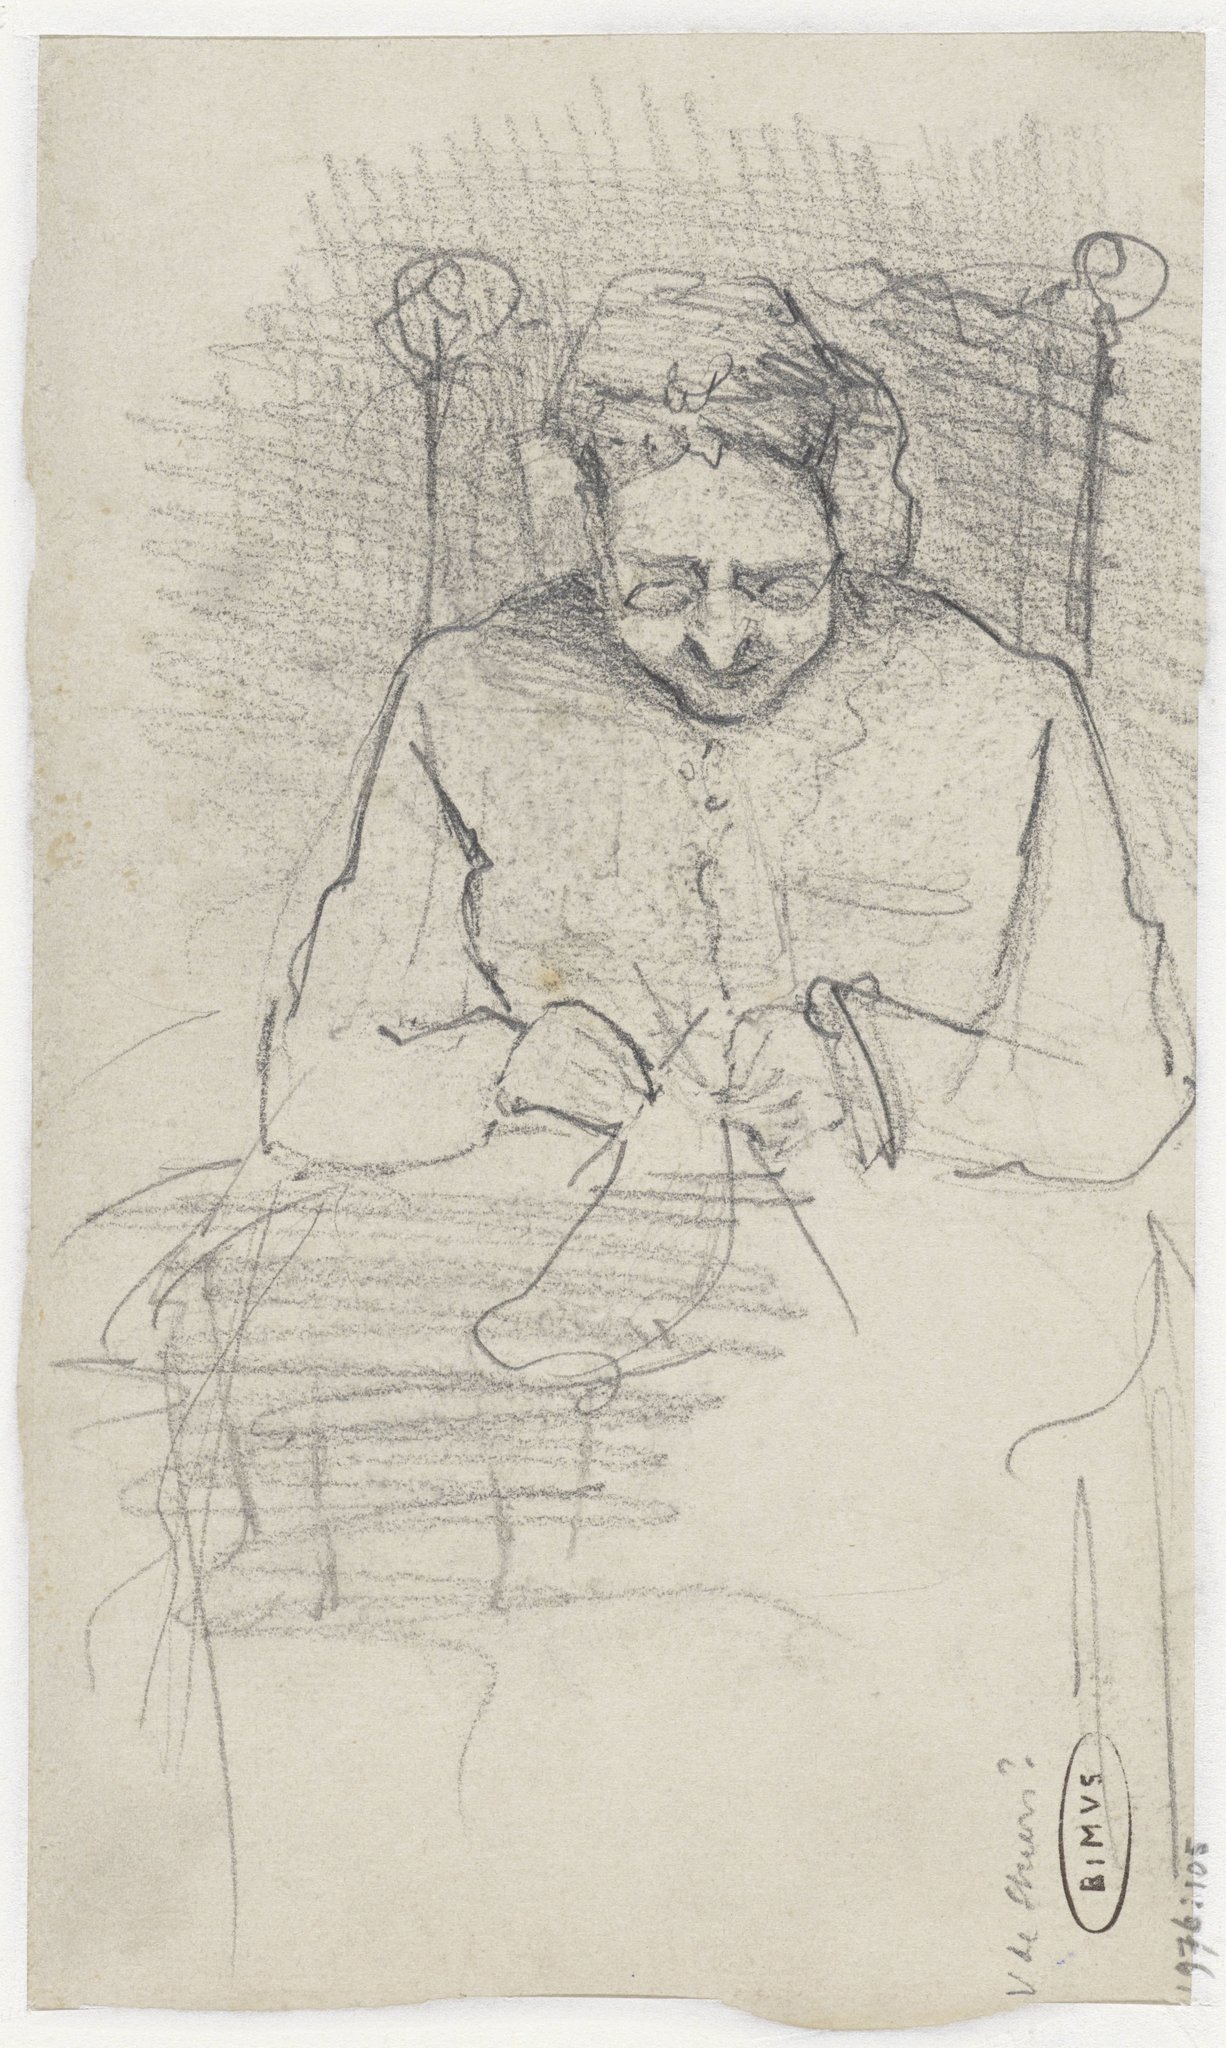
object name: drawing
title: Zittende, breiende vrouw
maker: a.a.l. de grammont-hubrecht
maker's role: draughtsman, painter, print maker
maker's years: 1855-1913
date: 1865-1913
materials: paper, pencil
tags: (other forms of) needlework, e.g.: crocheting, knitting, embroidering